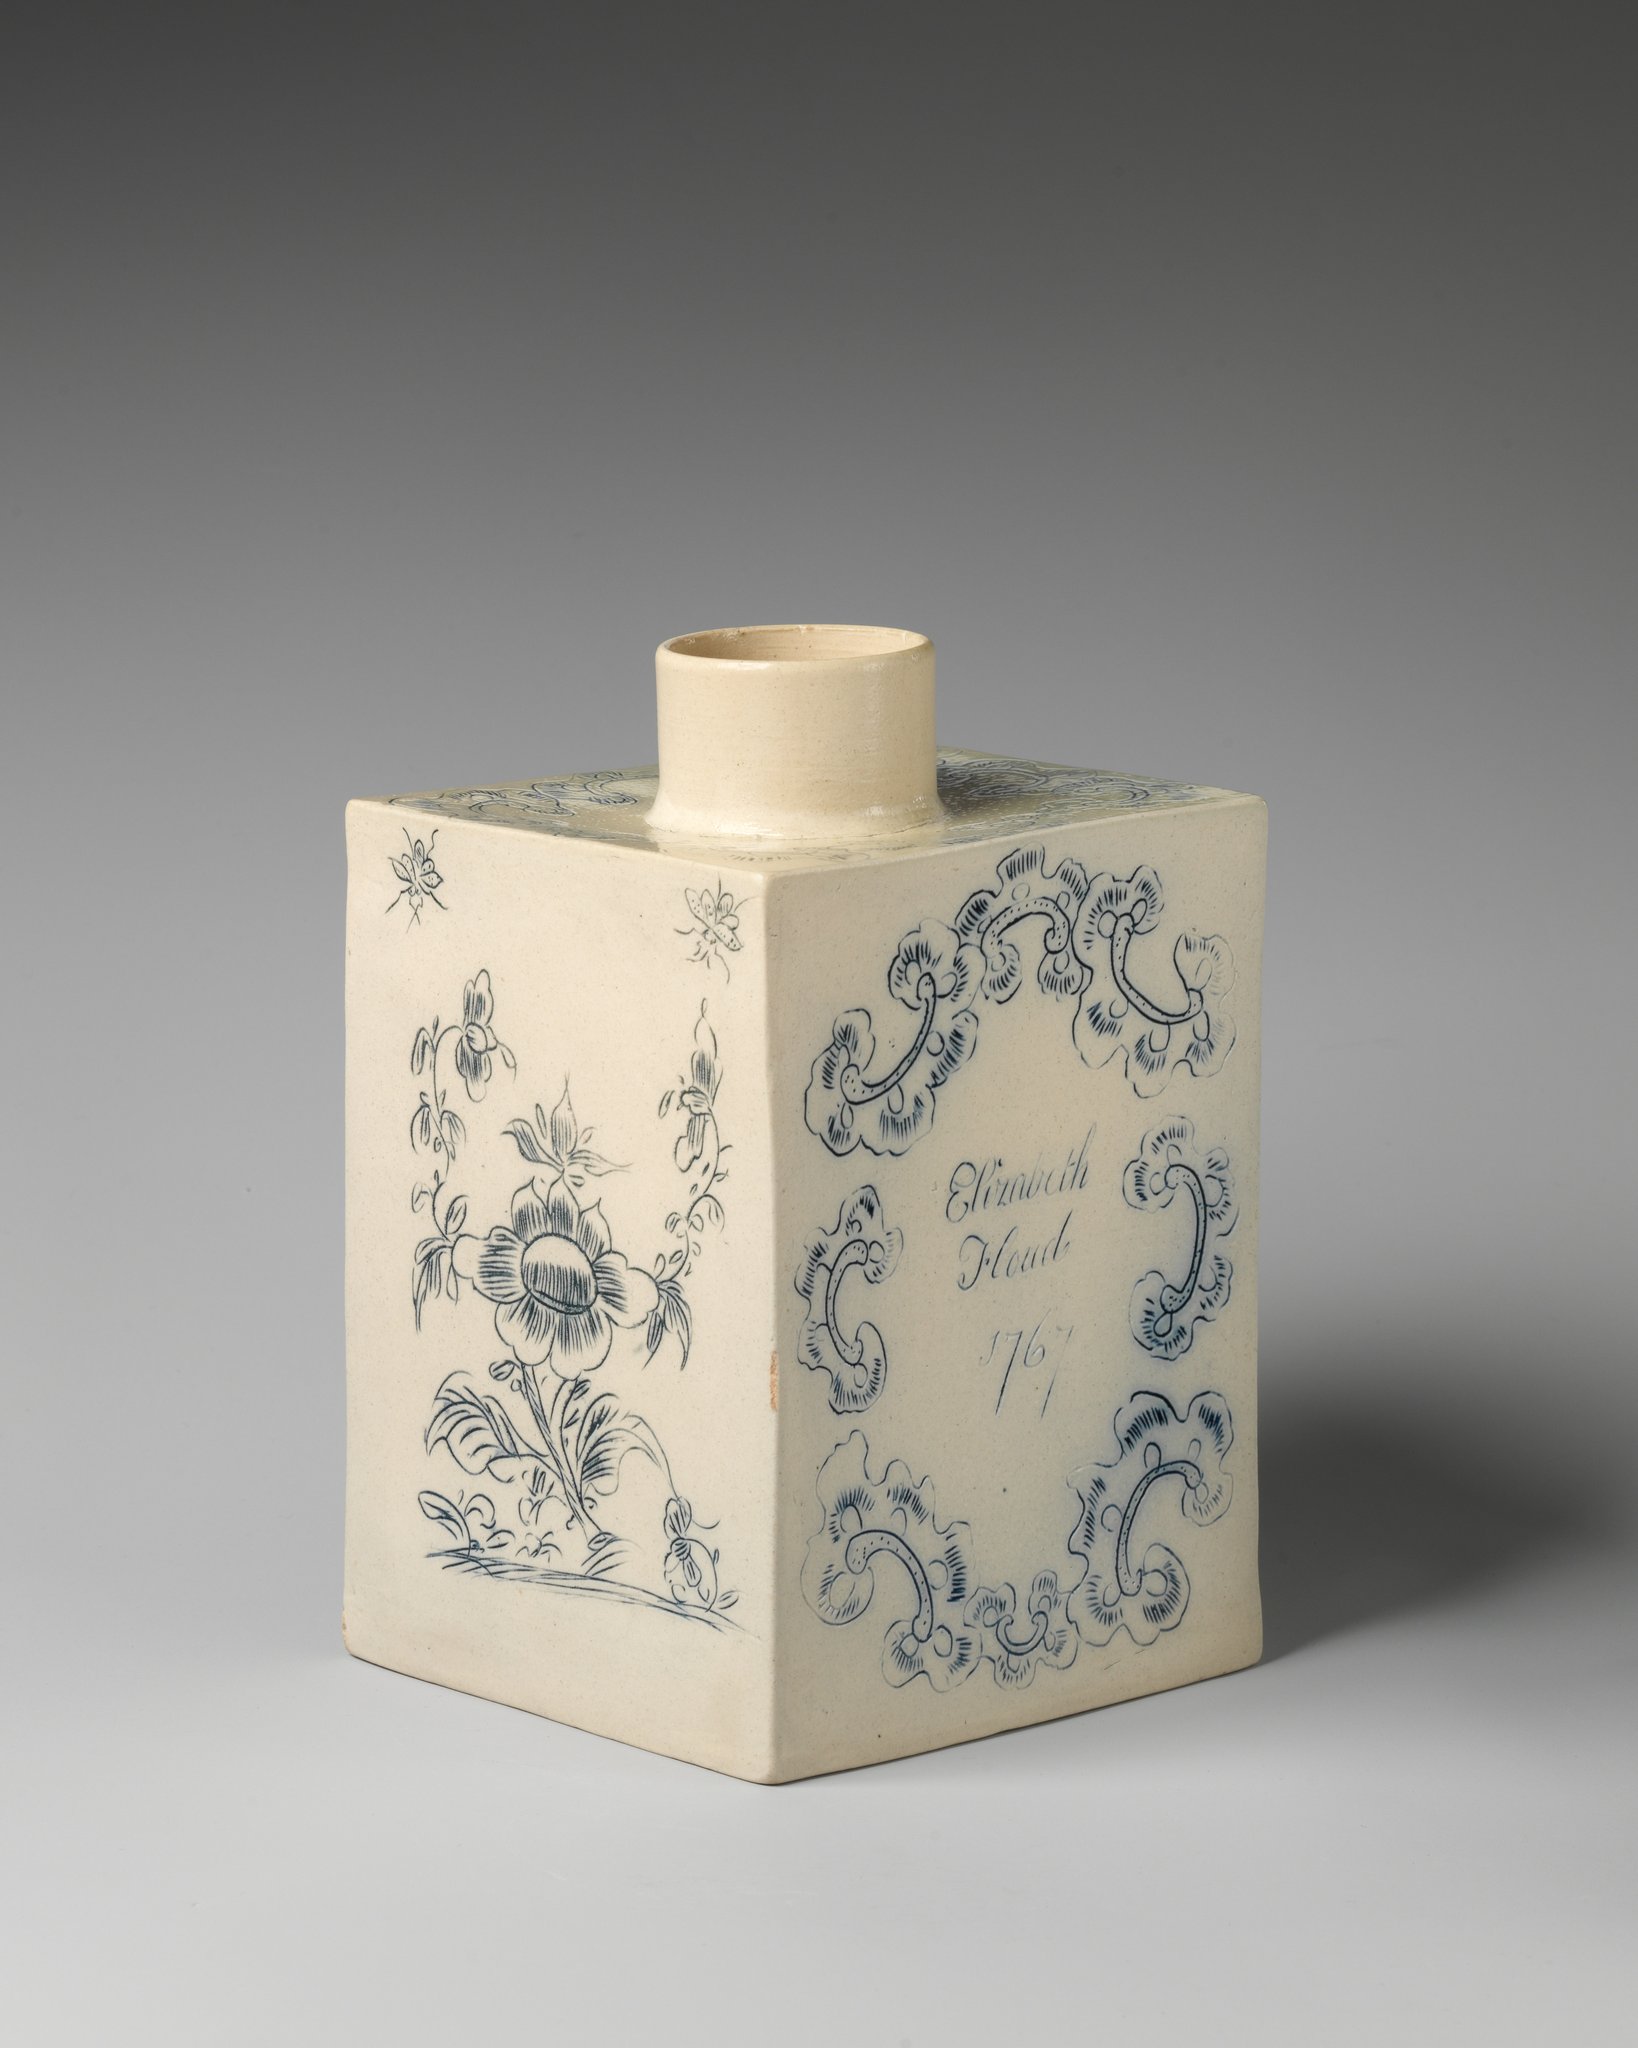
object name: tea caddy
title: Tea caddy incised with “Elizabeth Floud 1767”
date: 1767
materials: stoneware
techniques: salt glaze, underglaze